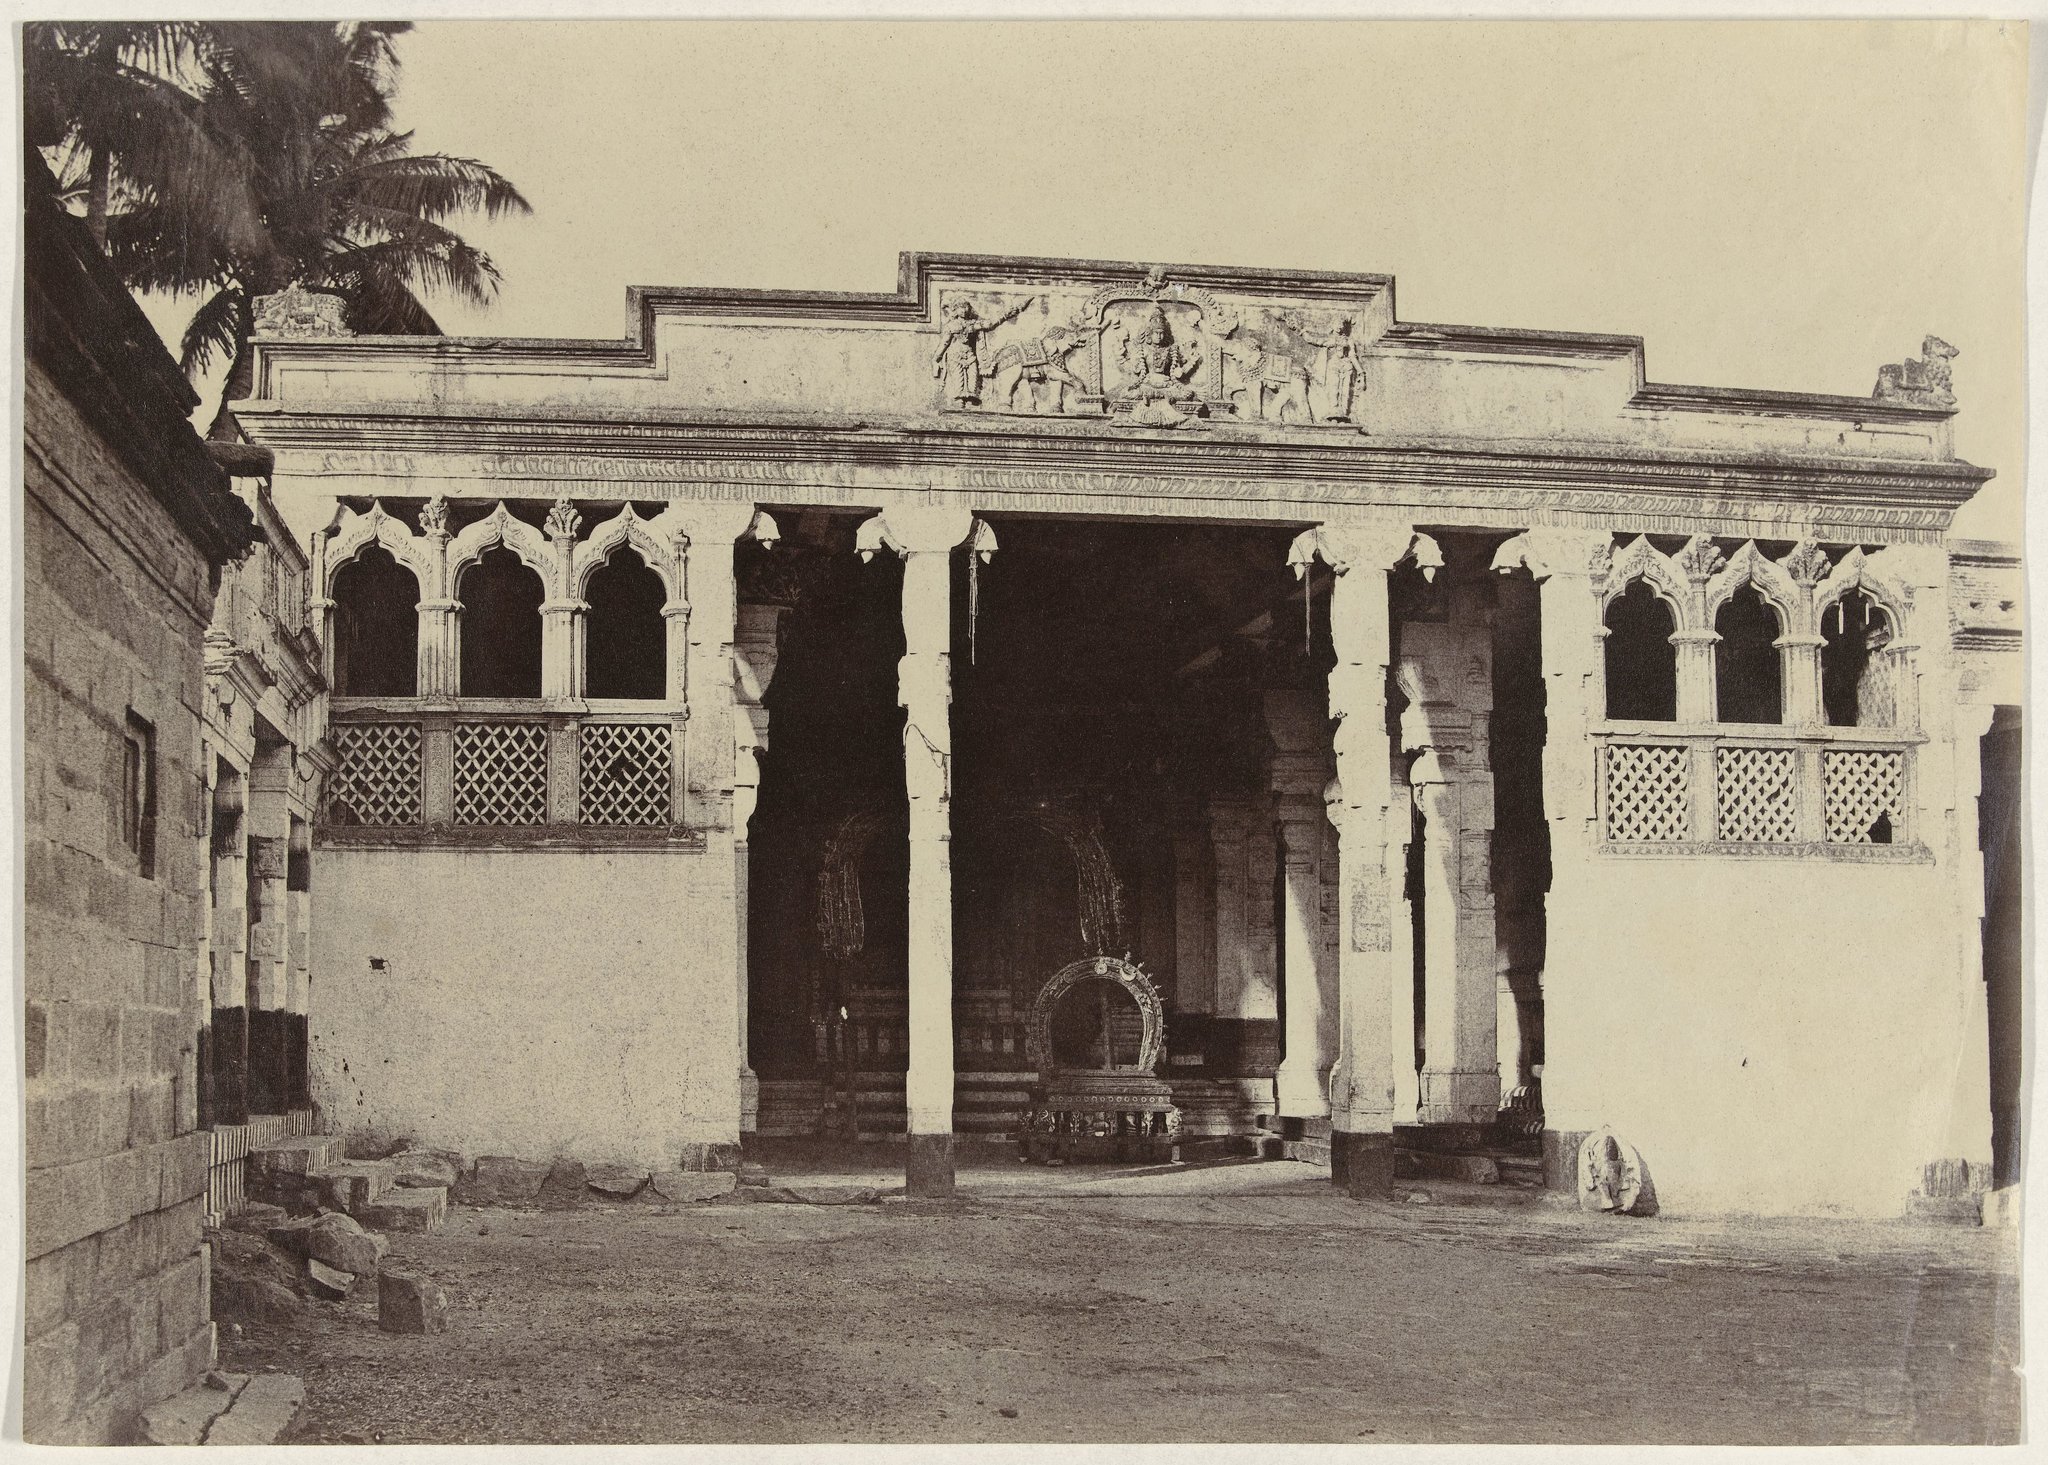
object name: photograph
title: Entrance of the Meenakshi temple at Madurai, Tamil Nadu, India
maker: linnaeus tripe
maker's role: fotograaf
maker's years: 1822-1902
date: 1858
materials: paper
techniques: albumen print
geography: madurai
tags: temple, shrine ~ hinduism, buddhism, jainism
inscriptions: inscription: ‘PP’